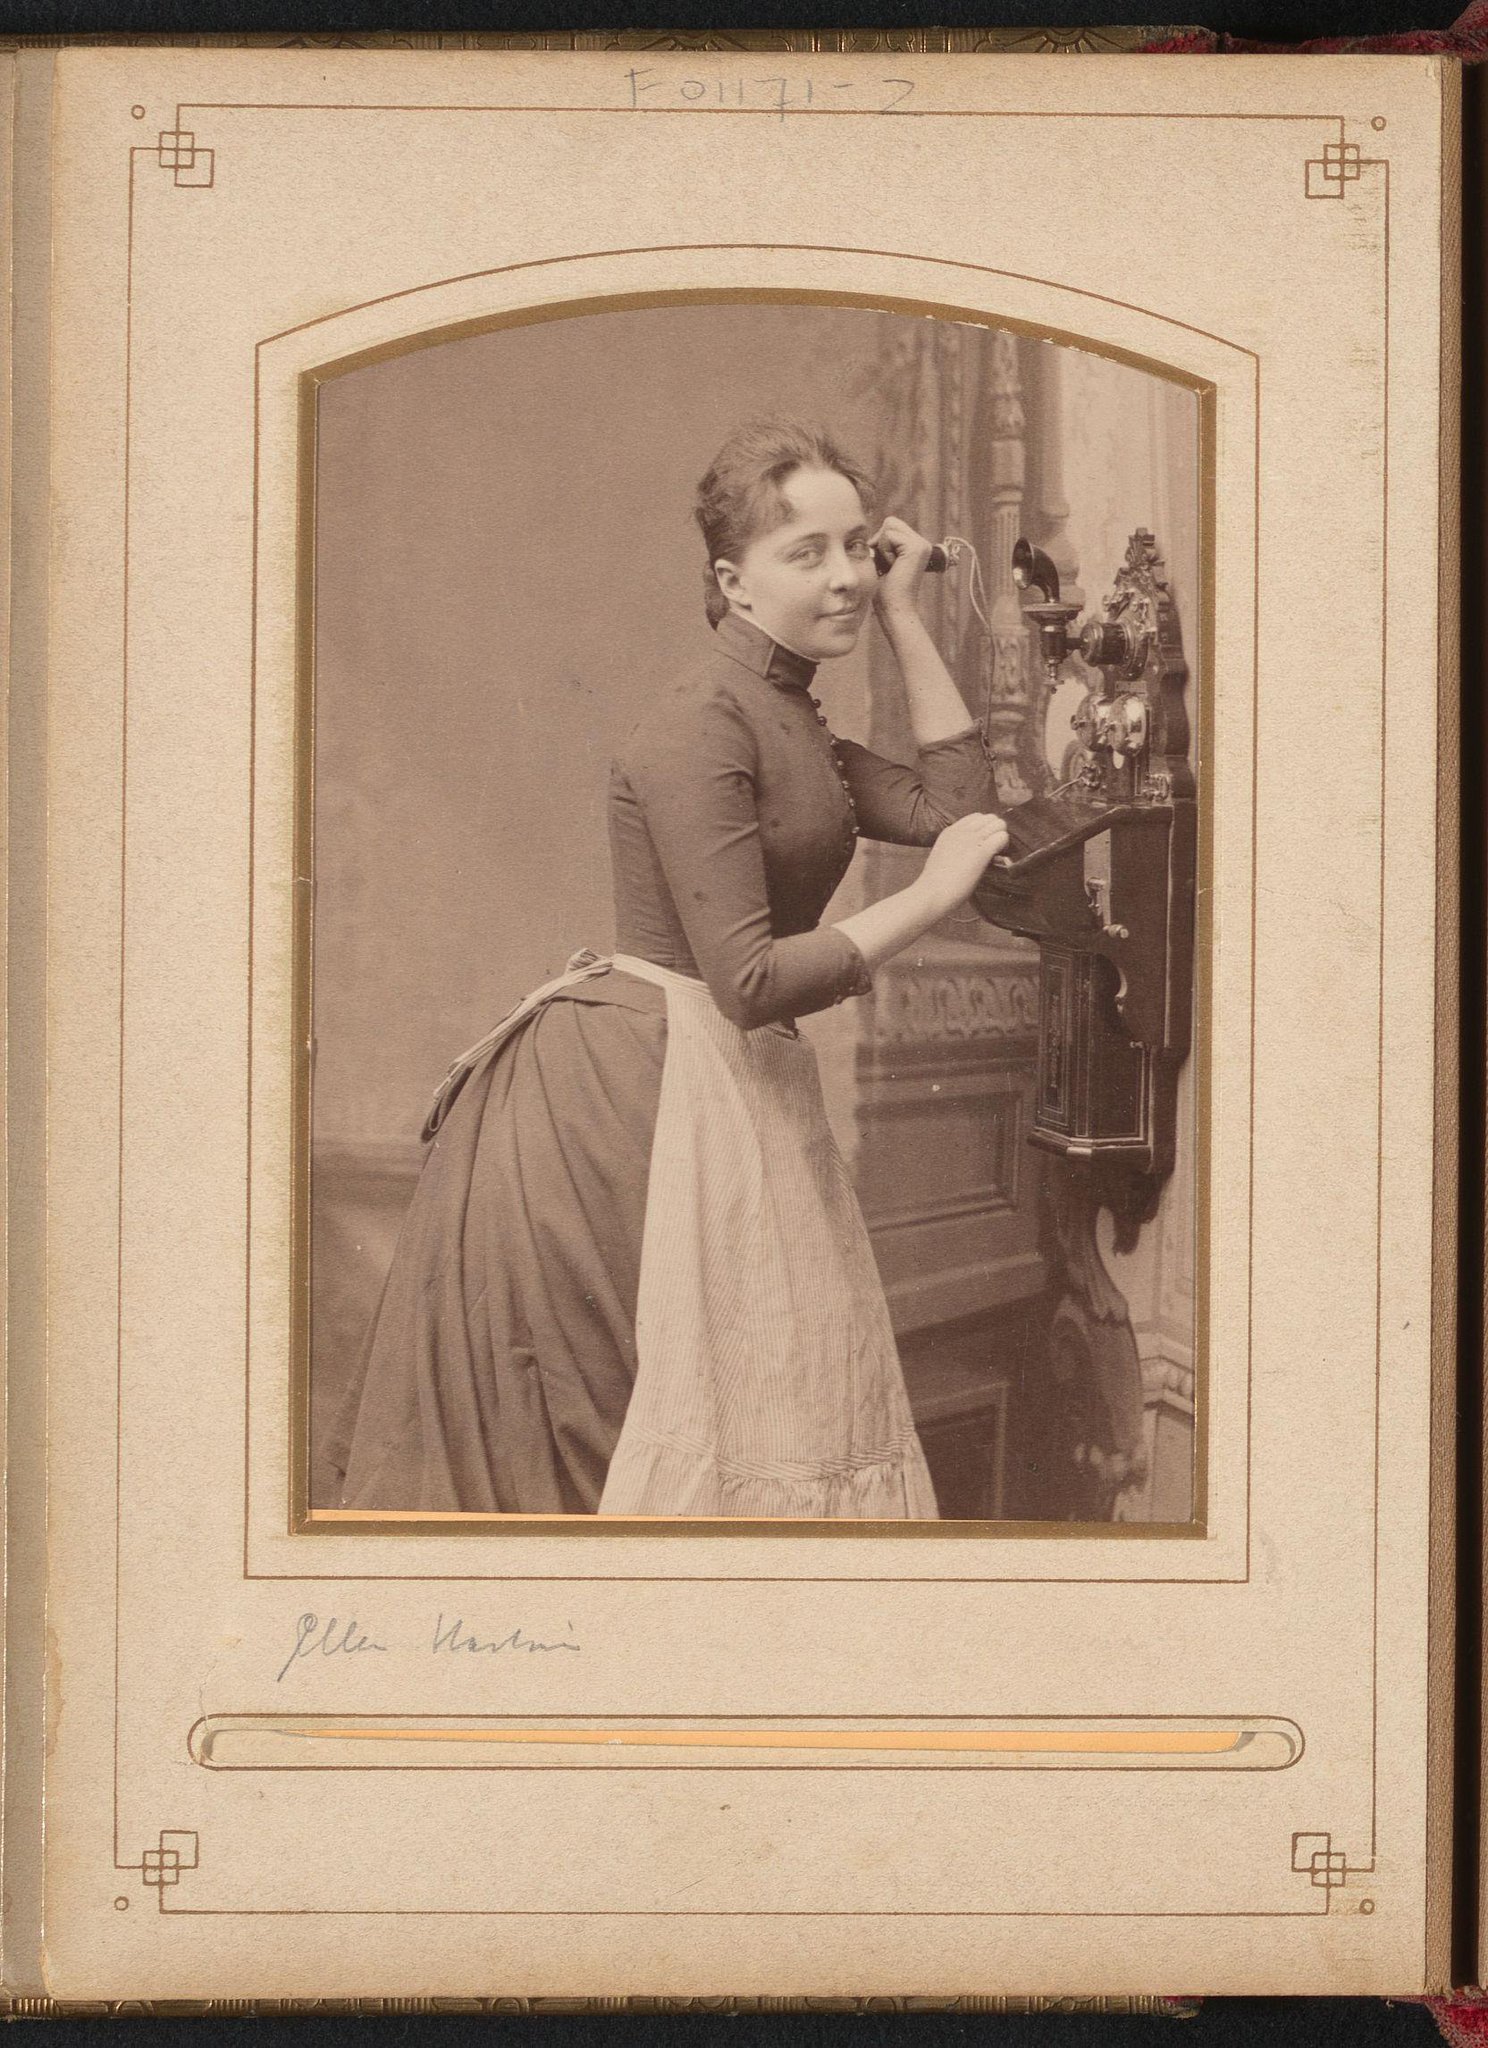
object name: photograph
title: Portret van Ellen Hartman met telefoontoestel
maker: gösta florman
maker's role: fotograaf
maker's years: 1831-1900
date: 1880-1890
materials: cardboard, photographic support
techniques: albumen print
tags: adult woman, telephone, portrait of actor, actress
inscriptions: annotation: ‘Teefon/ Ellen Hartman [...]’, inscription: ‘Gosta Florman/ 28A Regeringsgatan 28A/ Stockholm/ N.P.’, name: ‘Gösta Florman’